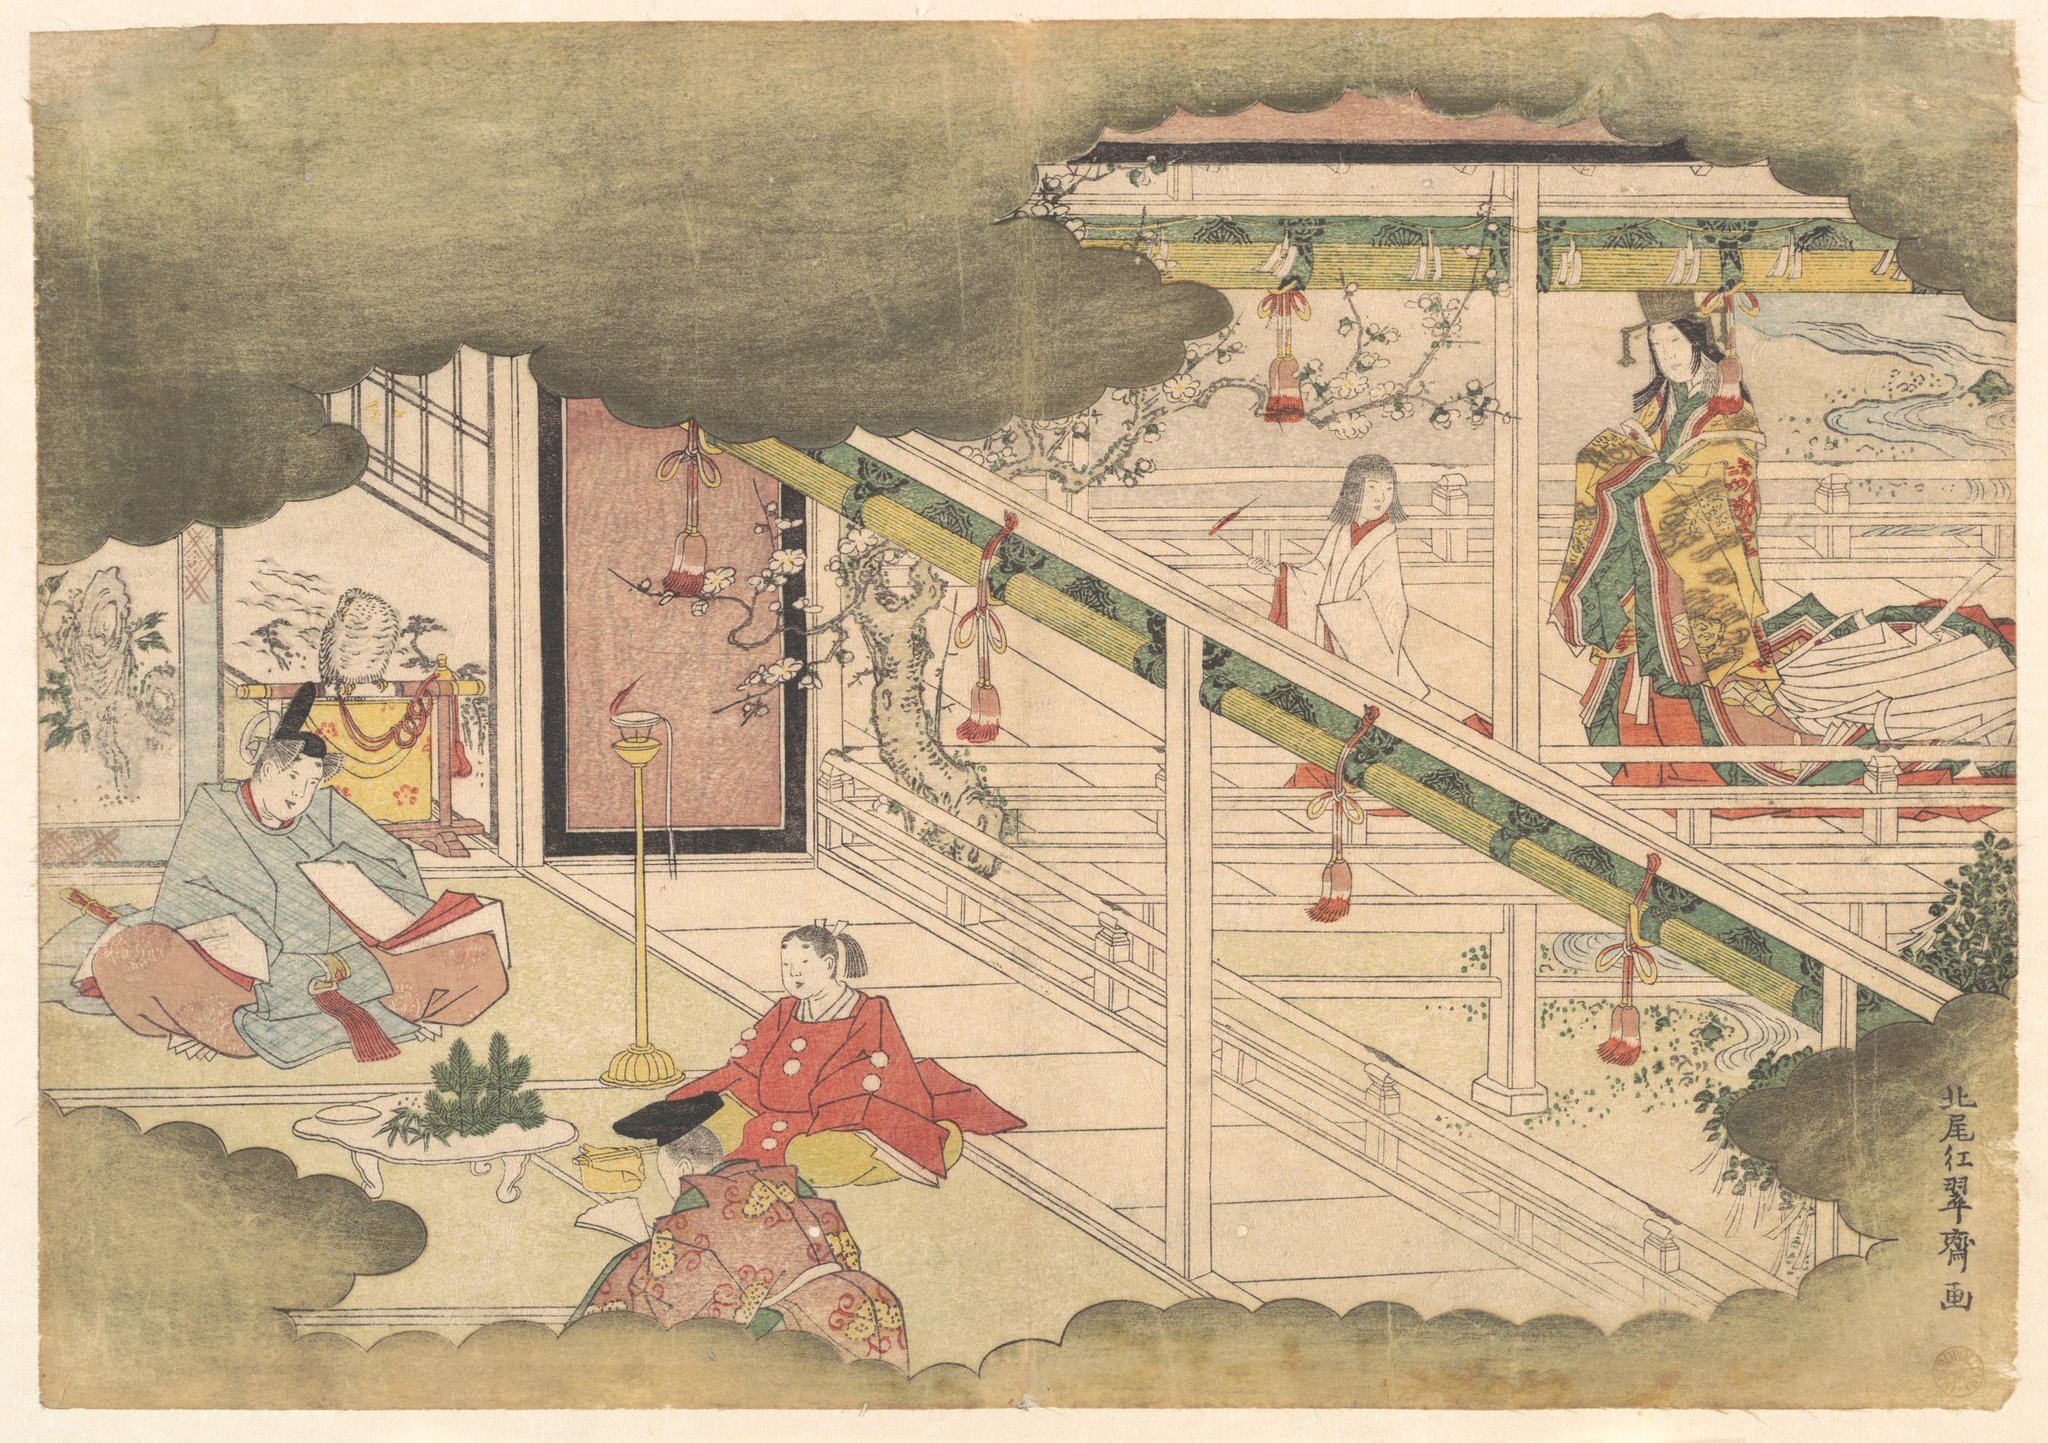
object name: print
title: An Incident from the Tales of Ise (Ise Monogatari)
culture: japanese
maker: kitao shigemasa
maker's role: artist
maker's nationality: japanese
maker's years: 1739-1820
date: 1790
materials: ink, paper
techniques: woodblock print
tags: girls,men,women,trees